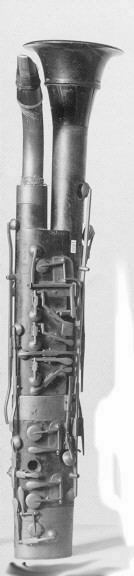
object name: bass clarinet in c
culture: german or italian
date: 1800-1850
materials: brass, wood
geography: italy